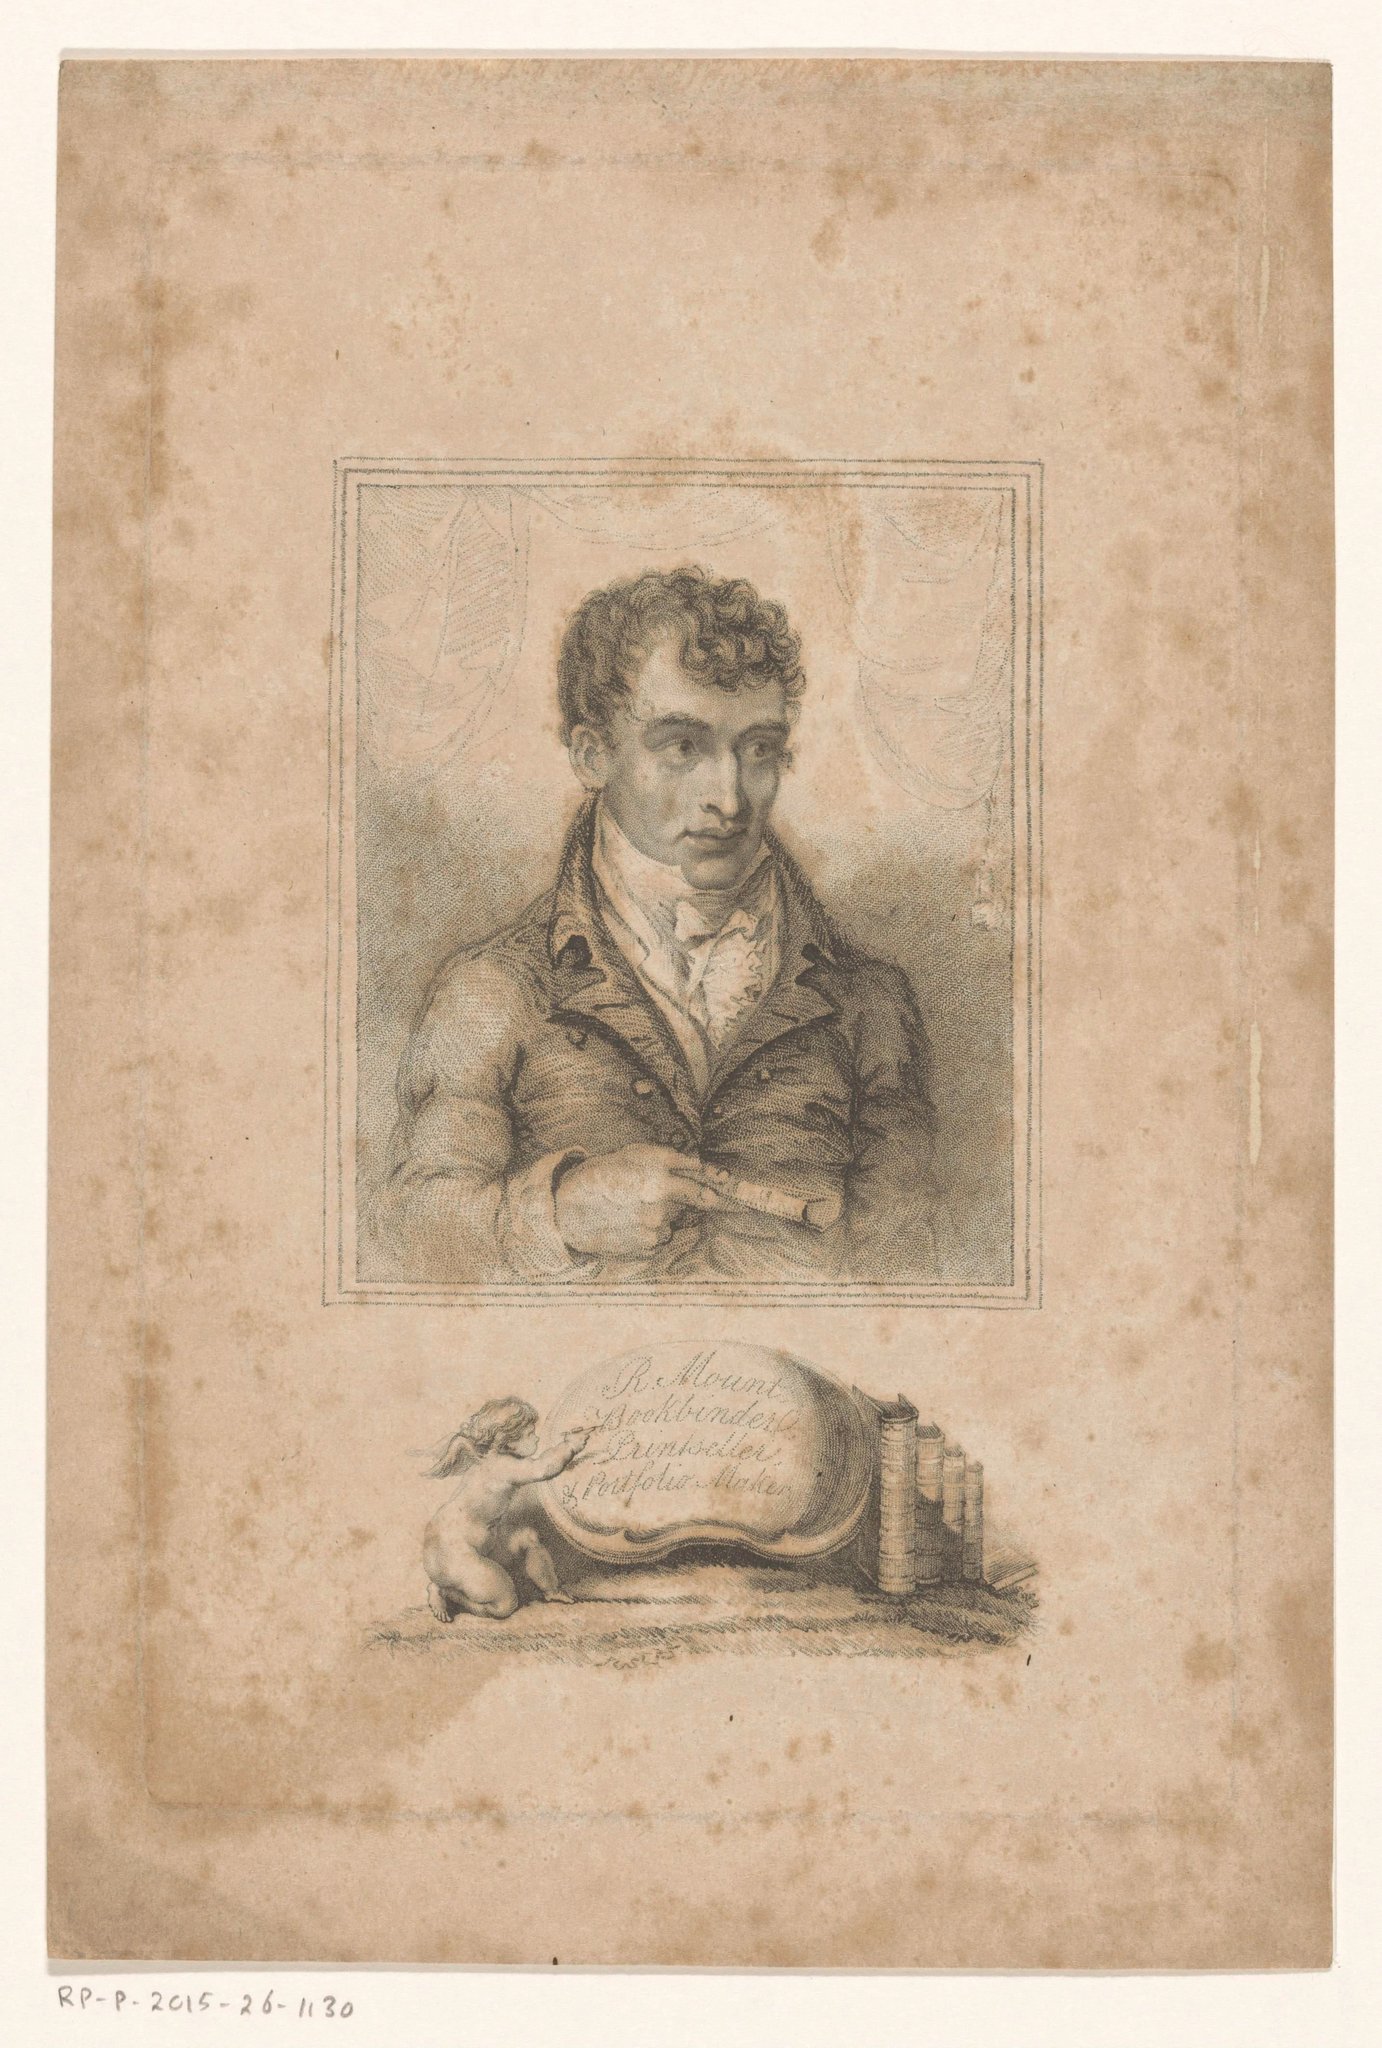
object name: print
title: Portret van Robert Mount, boekbinder en prentverkoper te Londen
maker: Anonymous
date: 1800-1850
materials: paper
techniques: roulette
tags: book, cupids: 'amores', 'amoretti', 'putti'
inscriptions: collector's mark: Lugt 2228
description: Onder het portret schrijft een putto de naam van de voorgestelde op een cartouche dat leunt tegen een rij boeken.